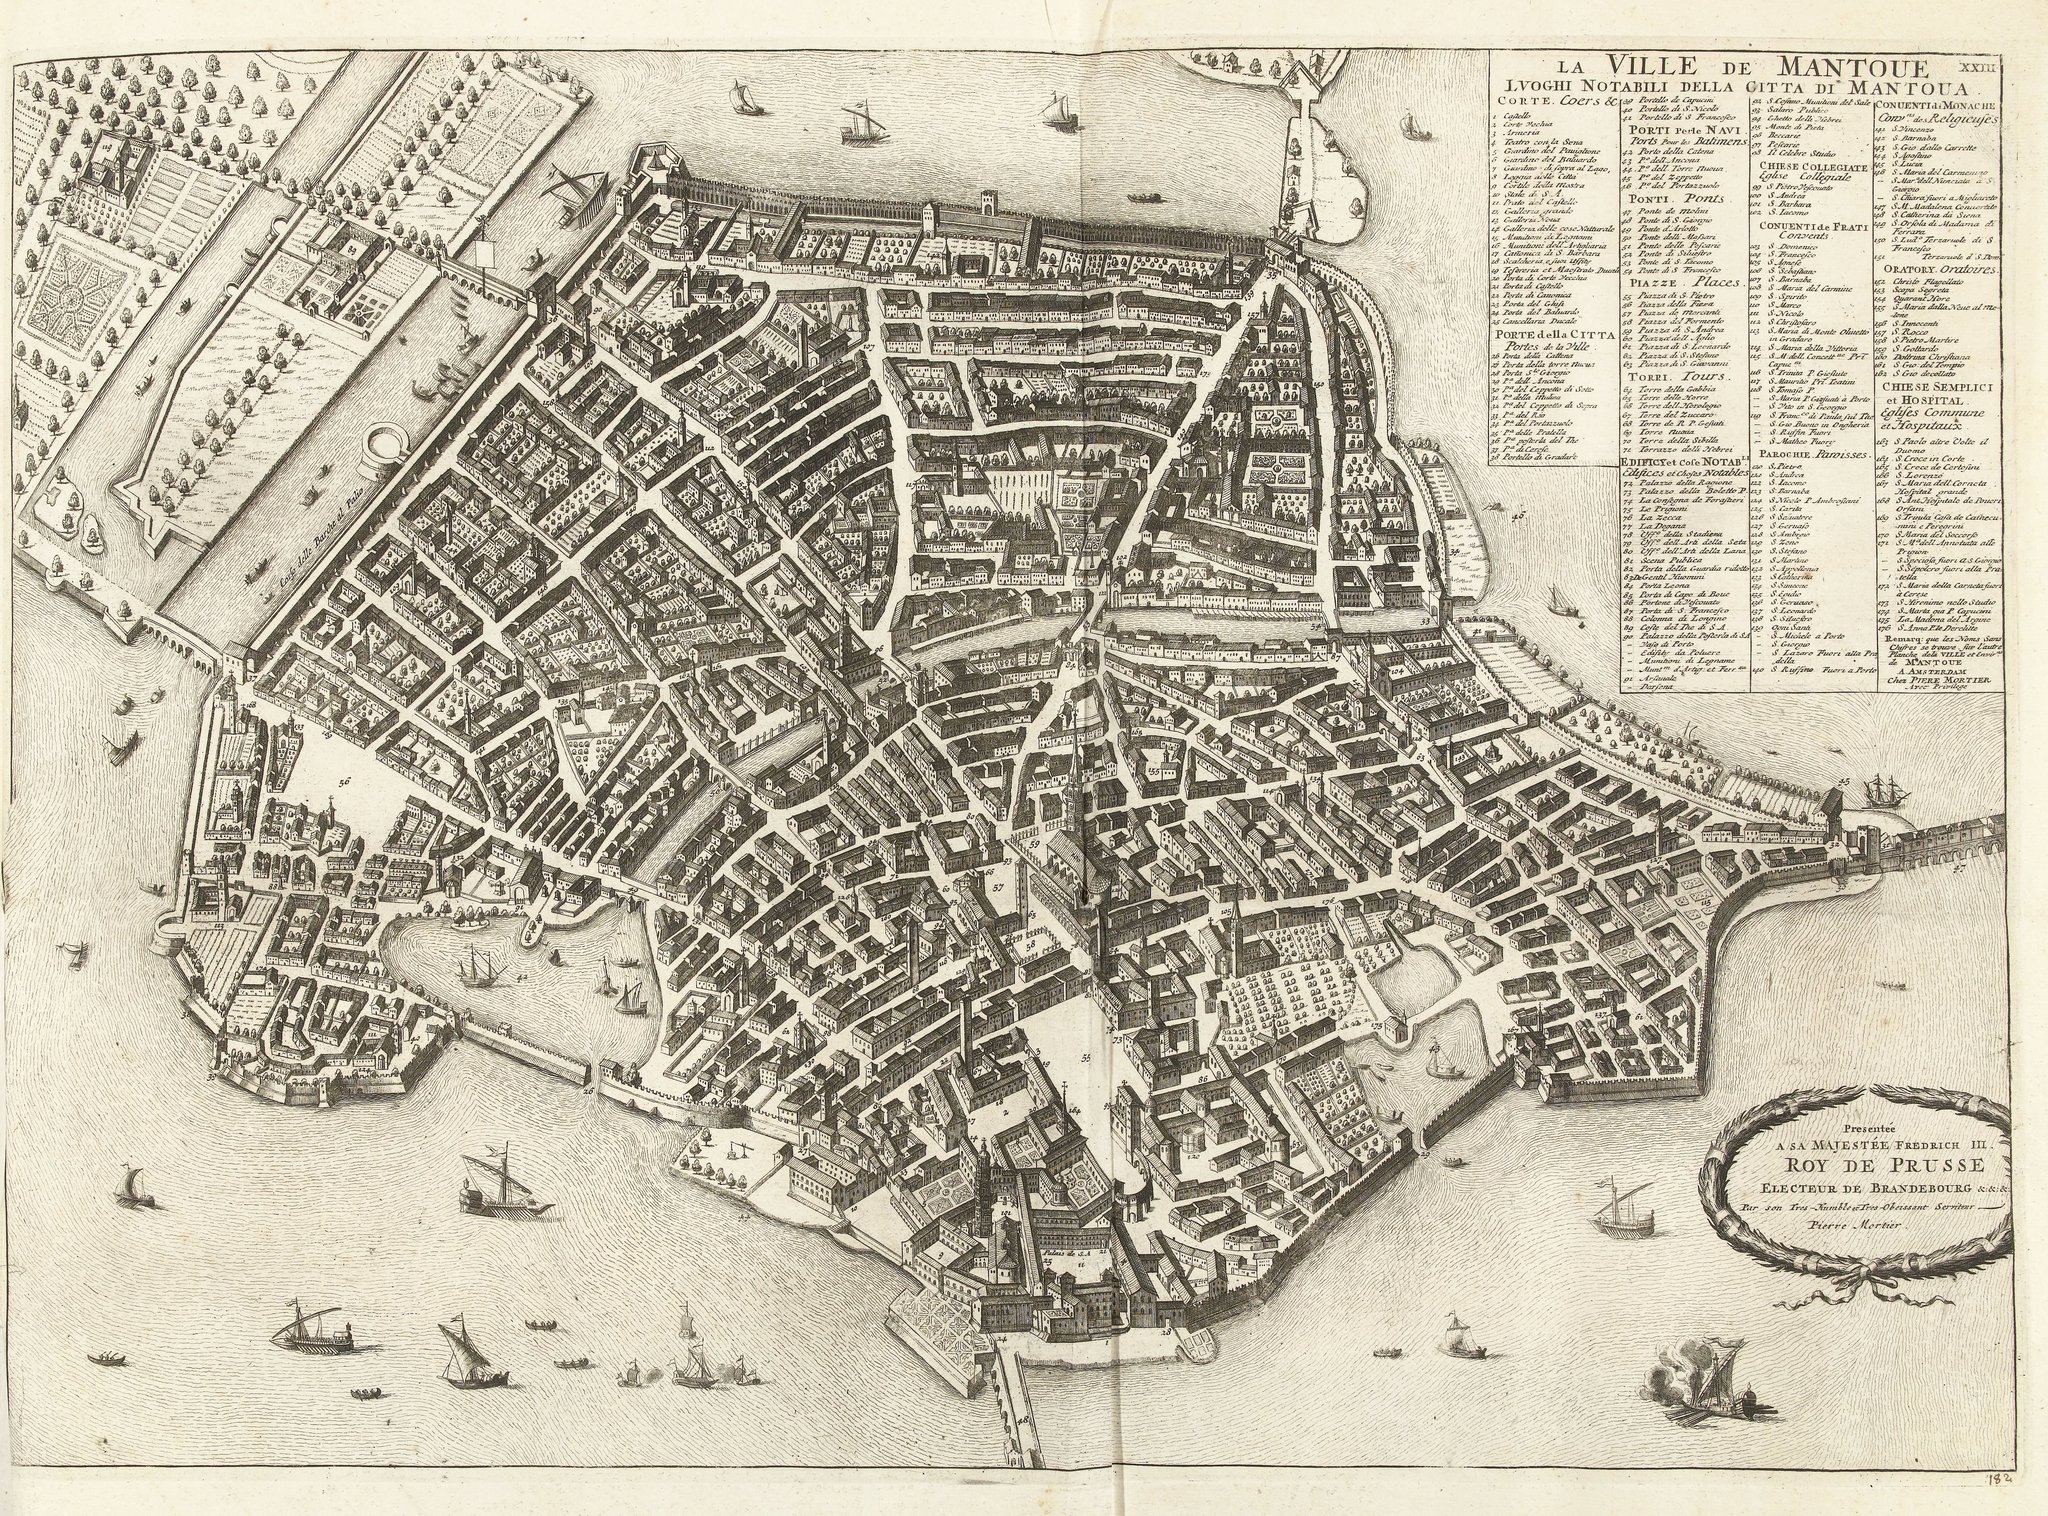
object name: print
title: Les Forces de l'Europe, Asie, Afrique et Amerique, ou description des principales villes avec leurs fortifications. Dessignées par les meilleurs ingenieurs, particulierement celles qui sont sous la domination de la France (...) et ornées de plusieurs superbes edifices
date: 1702-1703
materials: paper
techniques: etching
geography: amsterdam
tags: maps of cities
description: Grote plattegrond van de Italiaanse stad Mantua. Gemerkt rechtsboven: XXIII. Plaat nr. 182 in het prentwerk bestaande in totaal uit 276 genummerde platen van vermaarde sterke steden en vestingen in het kader van de Spaanse Successieoorlog. Voor het merendeel zijn deze platen gekopieerd naar de anonieme Franse platen: in Les forces de l'Europe en in: Le theatre de la guerre, dans les Pays-Bas, beide oorspronkelijk uitgegeven door Nicolas de Fer te Parijs (1693-1697) in het kader van de Negenjarige Oorlog. Titel en opschriften in de plaat in het Frans en Italiaans.